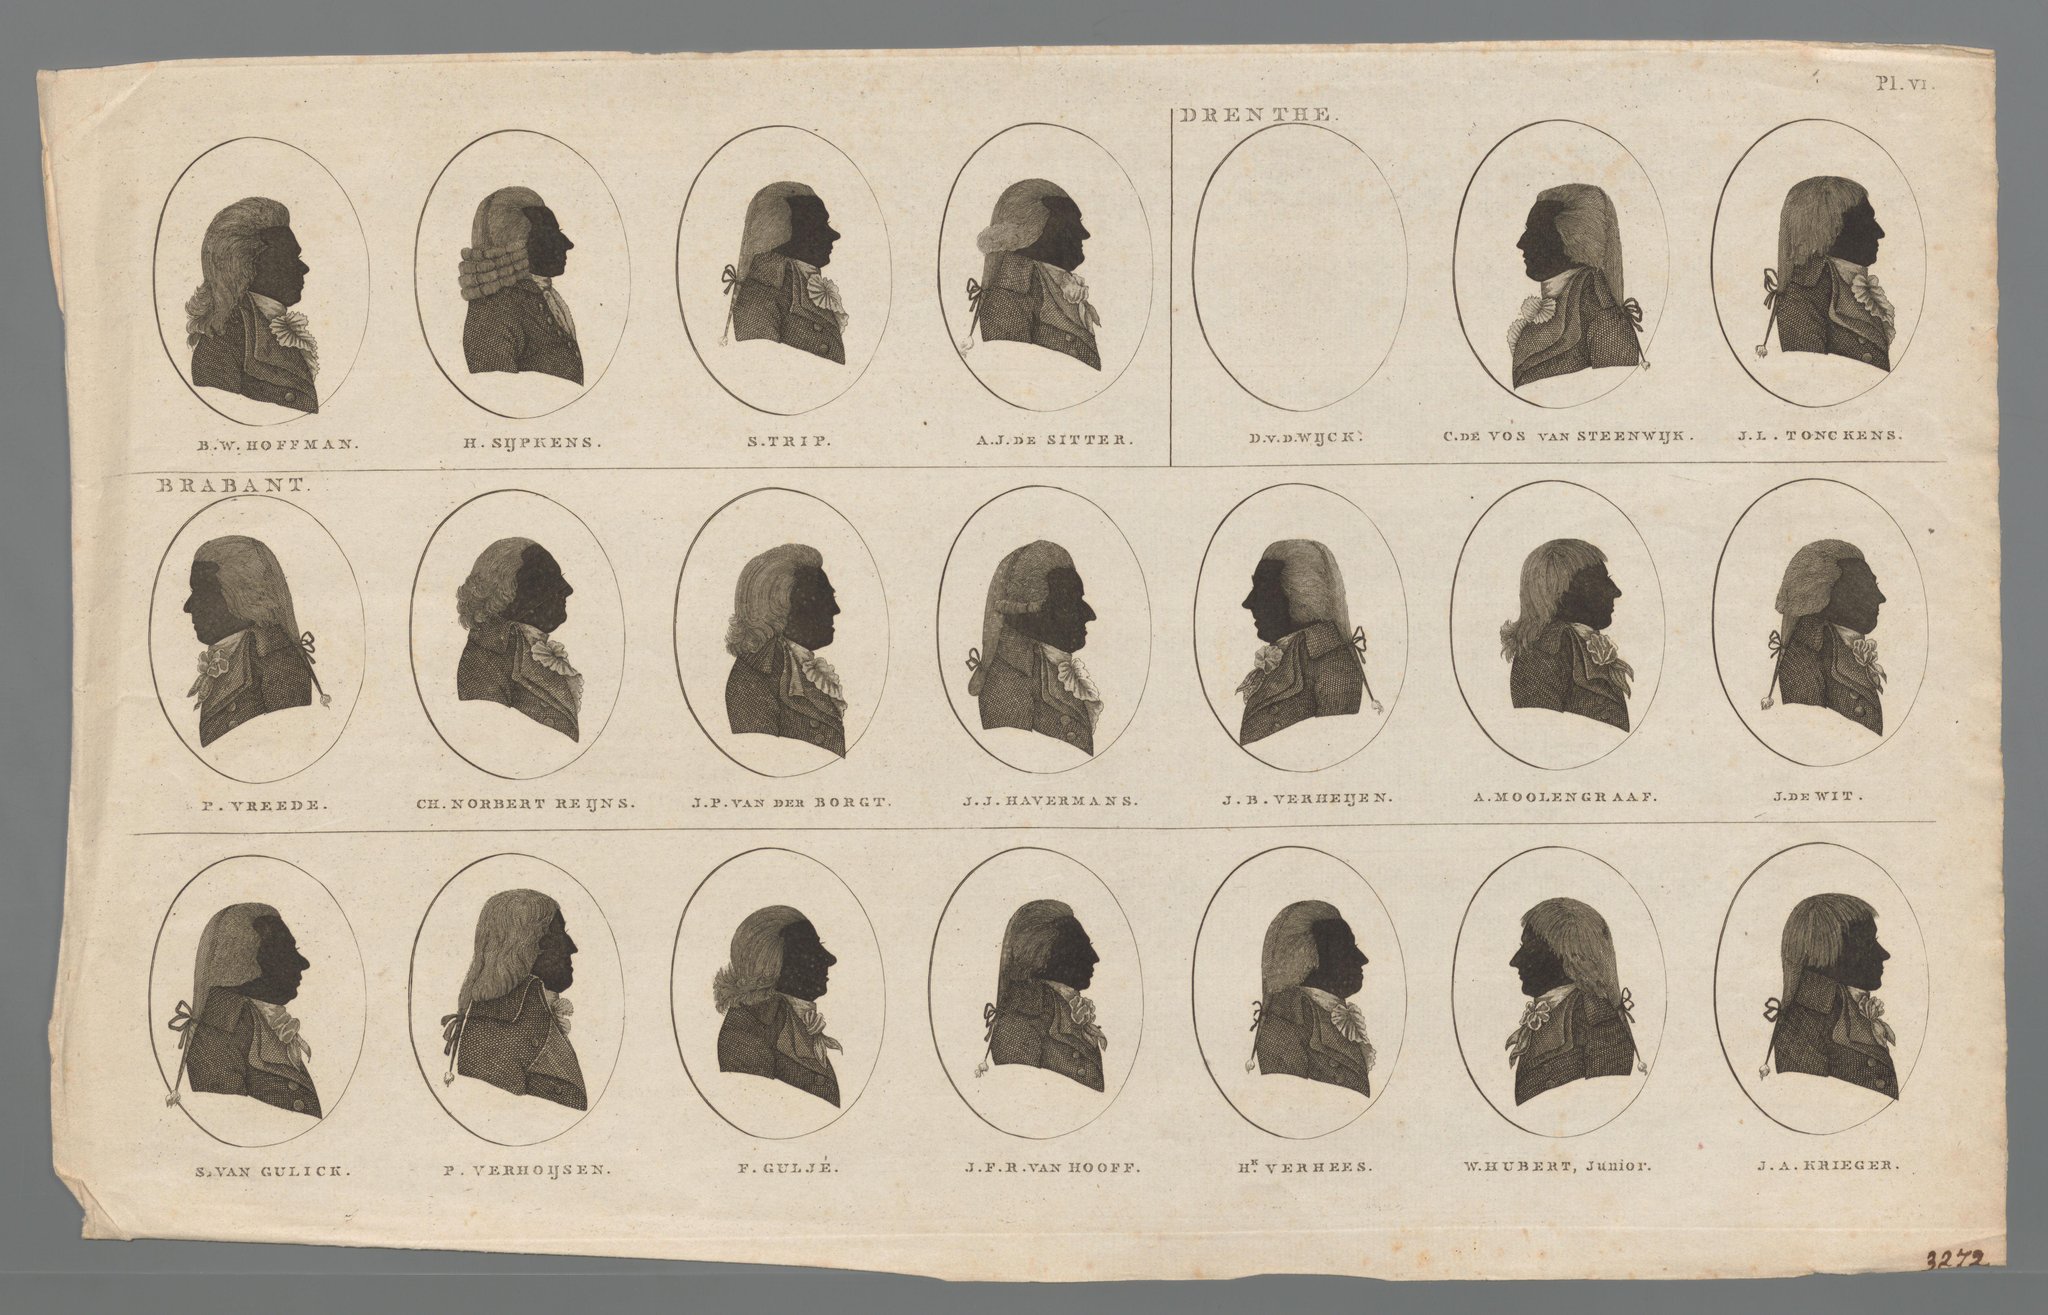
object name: print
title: Silhouetportretten van twintig Nederlandse politici uit Groningen en Drenthe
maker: Anonymous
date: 1799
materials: paper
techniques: etching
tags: politician, rosmalen, groningen (province), leiden, pieter vreede, priest, grave, utrecht, mayor, historical persons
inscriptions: collector's mark: Lugt 2228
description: Rechtsboven genummerd: Pl. VI. Portretten van Bernardus Wilhelmus Hoffman, Hendrik Sijpkens, Scato Trip, Albert Johan Sitter, Carel de Vos van Steenwijk, Joachimus Lunsingh Tonckens, Pieter Vreede, Christiaan Norbert Reijns, Johannes Petrus van der Borght, Johannes Josephus Havermans, Johannes Baptista Verheijen, A. Moolengraaf, J. de Wit, Stephanus van Gulick, Petrus Verhoijsen, Petrus Franciscus Guljé, Johan Frederik Rudolph van Hooff, Hendrick Verhees jr., Willem Pieter Hubert en Joannis Alexander Krieger.